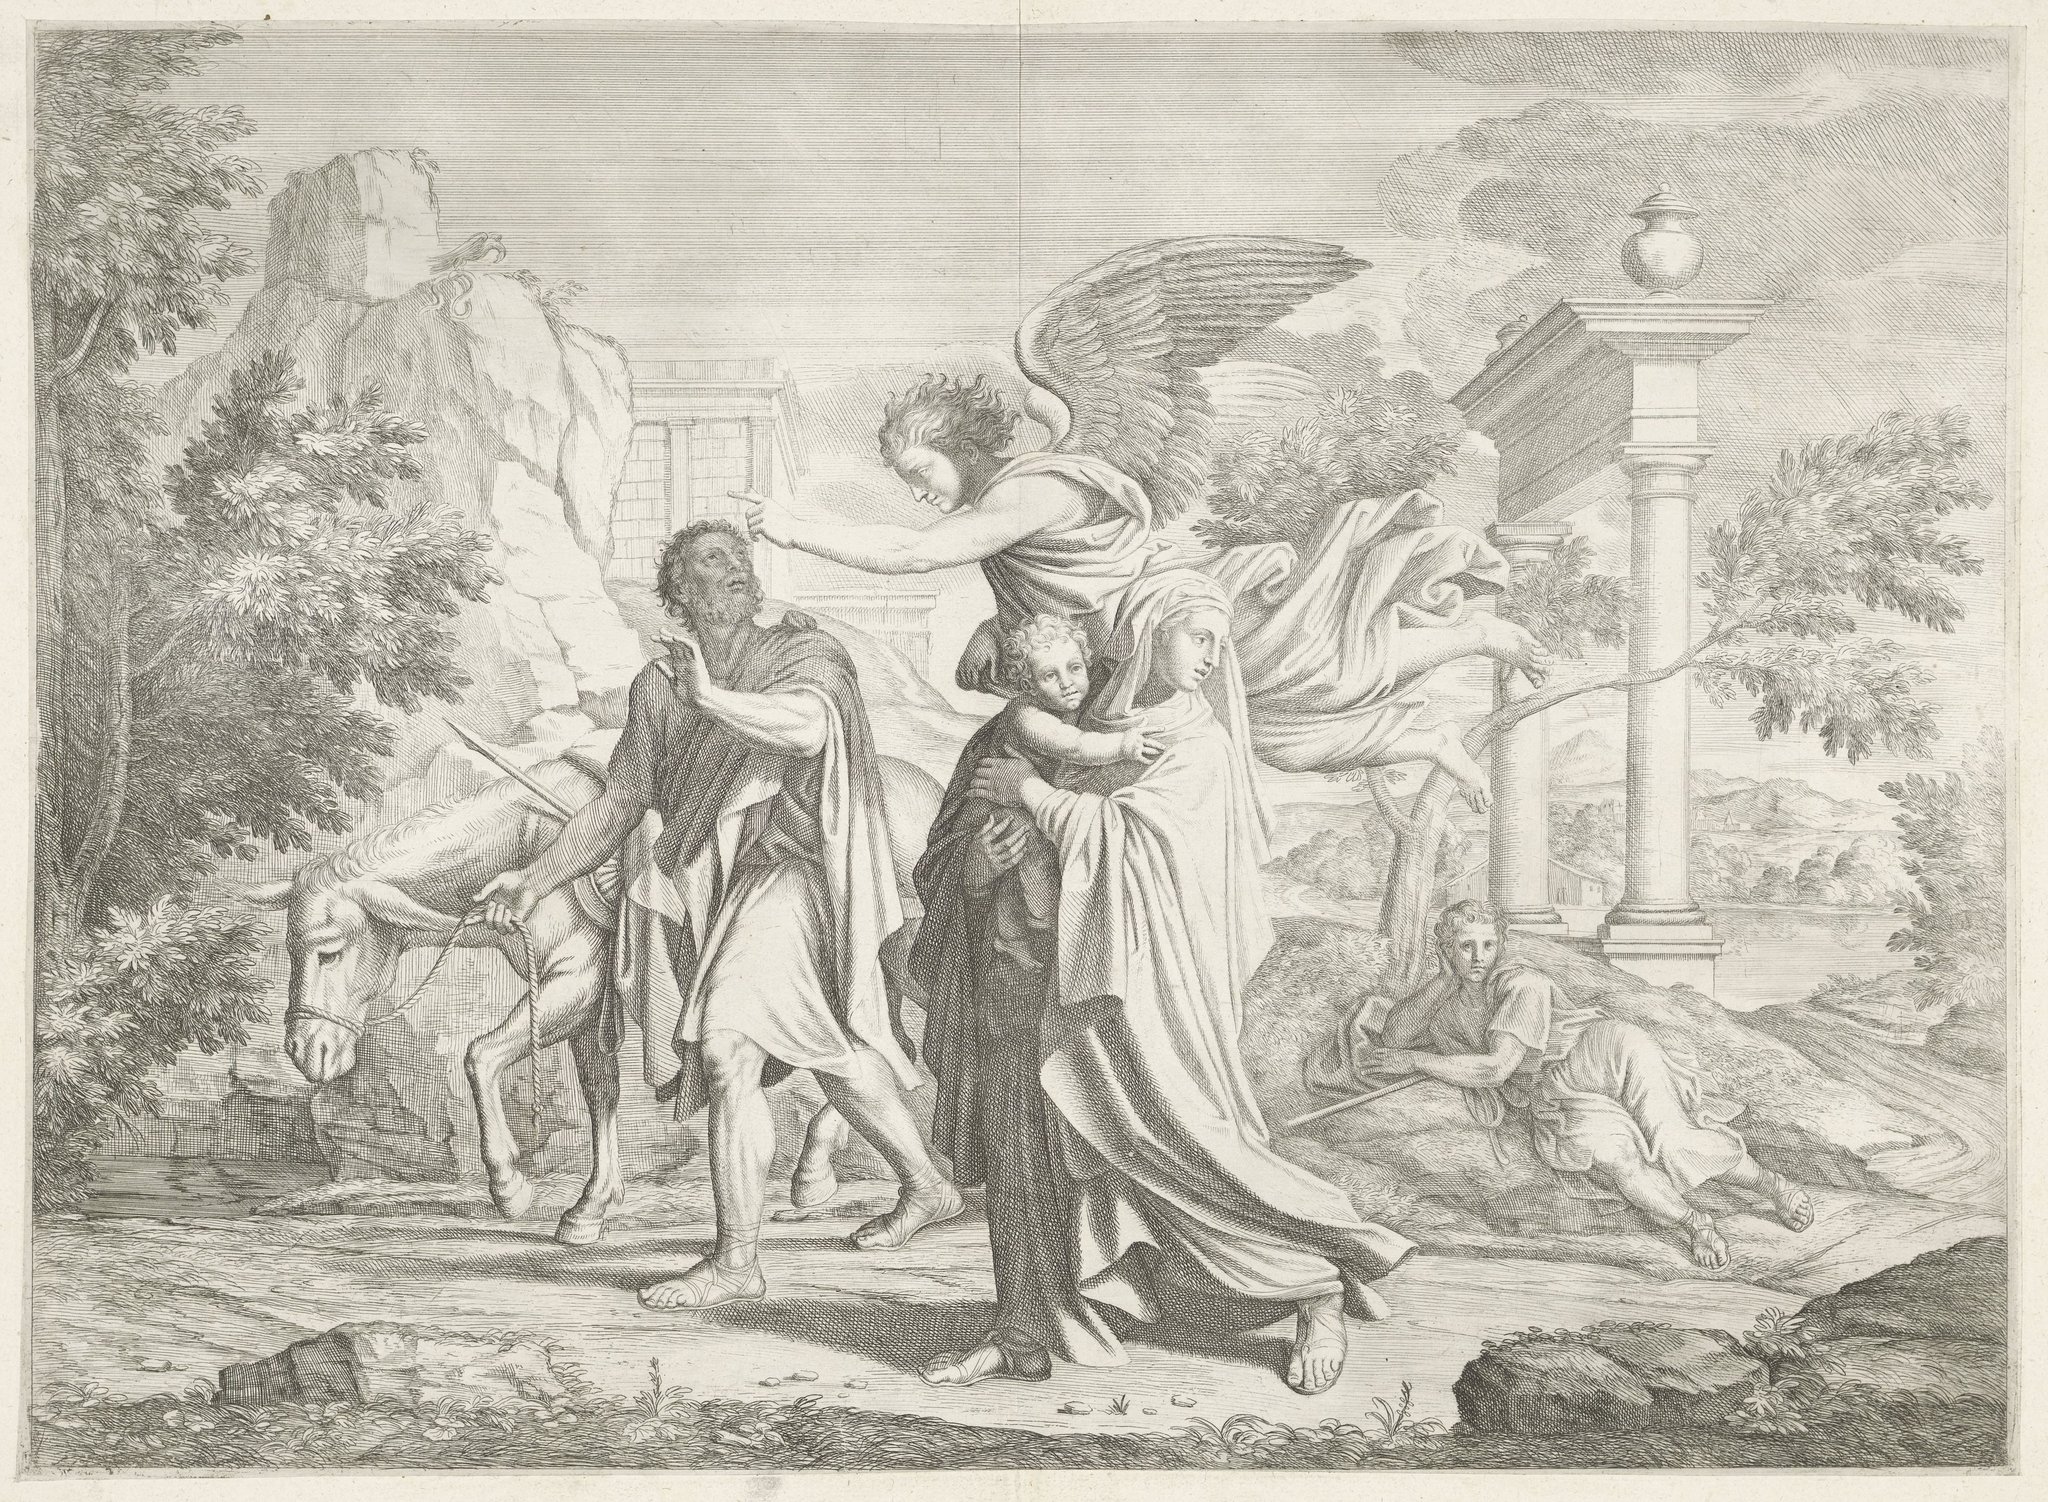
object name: print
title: Vlucht naar Egypte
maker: pietro del po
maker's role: print maker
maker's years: 1610-1692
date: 1620-1692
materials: paper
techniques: etching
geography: france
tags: the flight into egypt: mary, joseph, the child (and sometimes others) on their way; mary usually riding on an ass, angels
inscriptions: collector's mark: Lugt 240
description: De Heilige Familie met een ezel in een landschap met ruïnes. Een engel zweeft bij hen en wijst naar links. Rechts ligt een jongen in het gras.